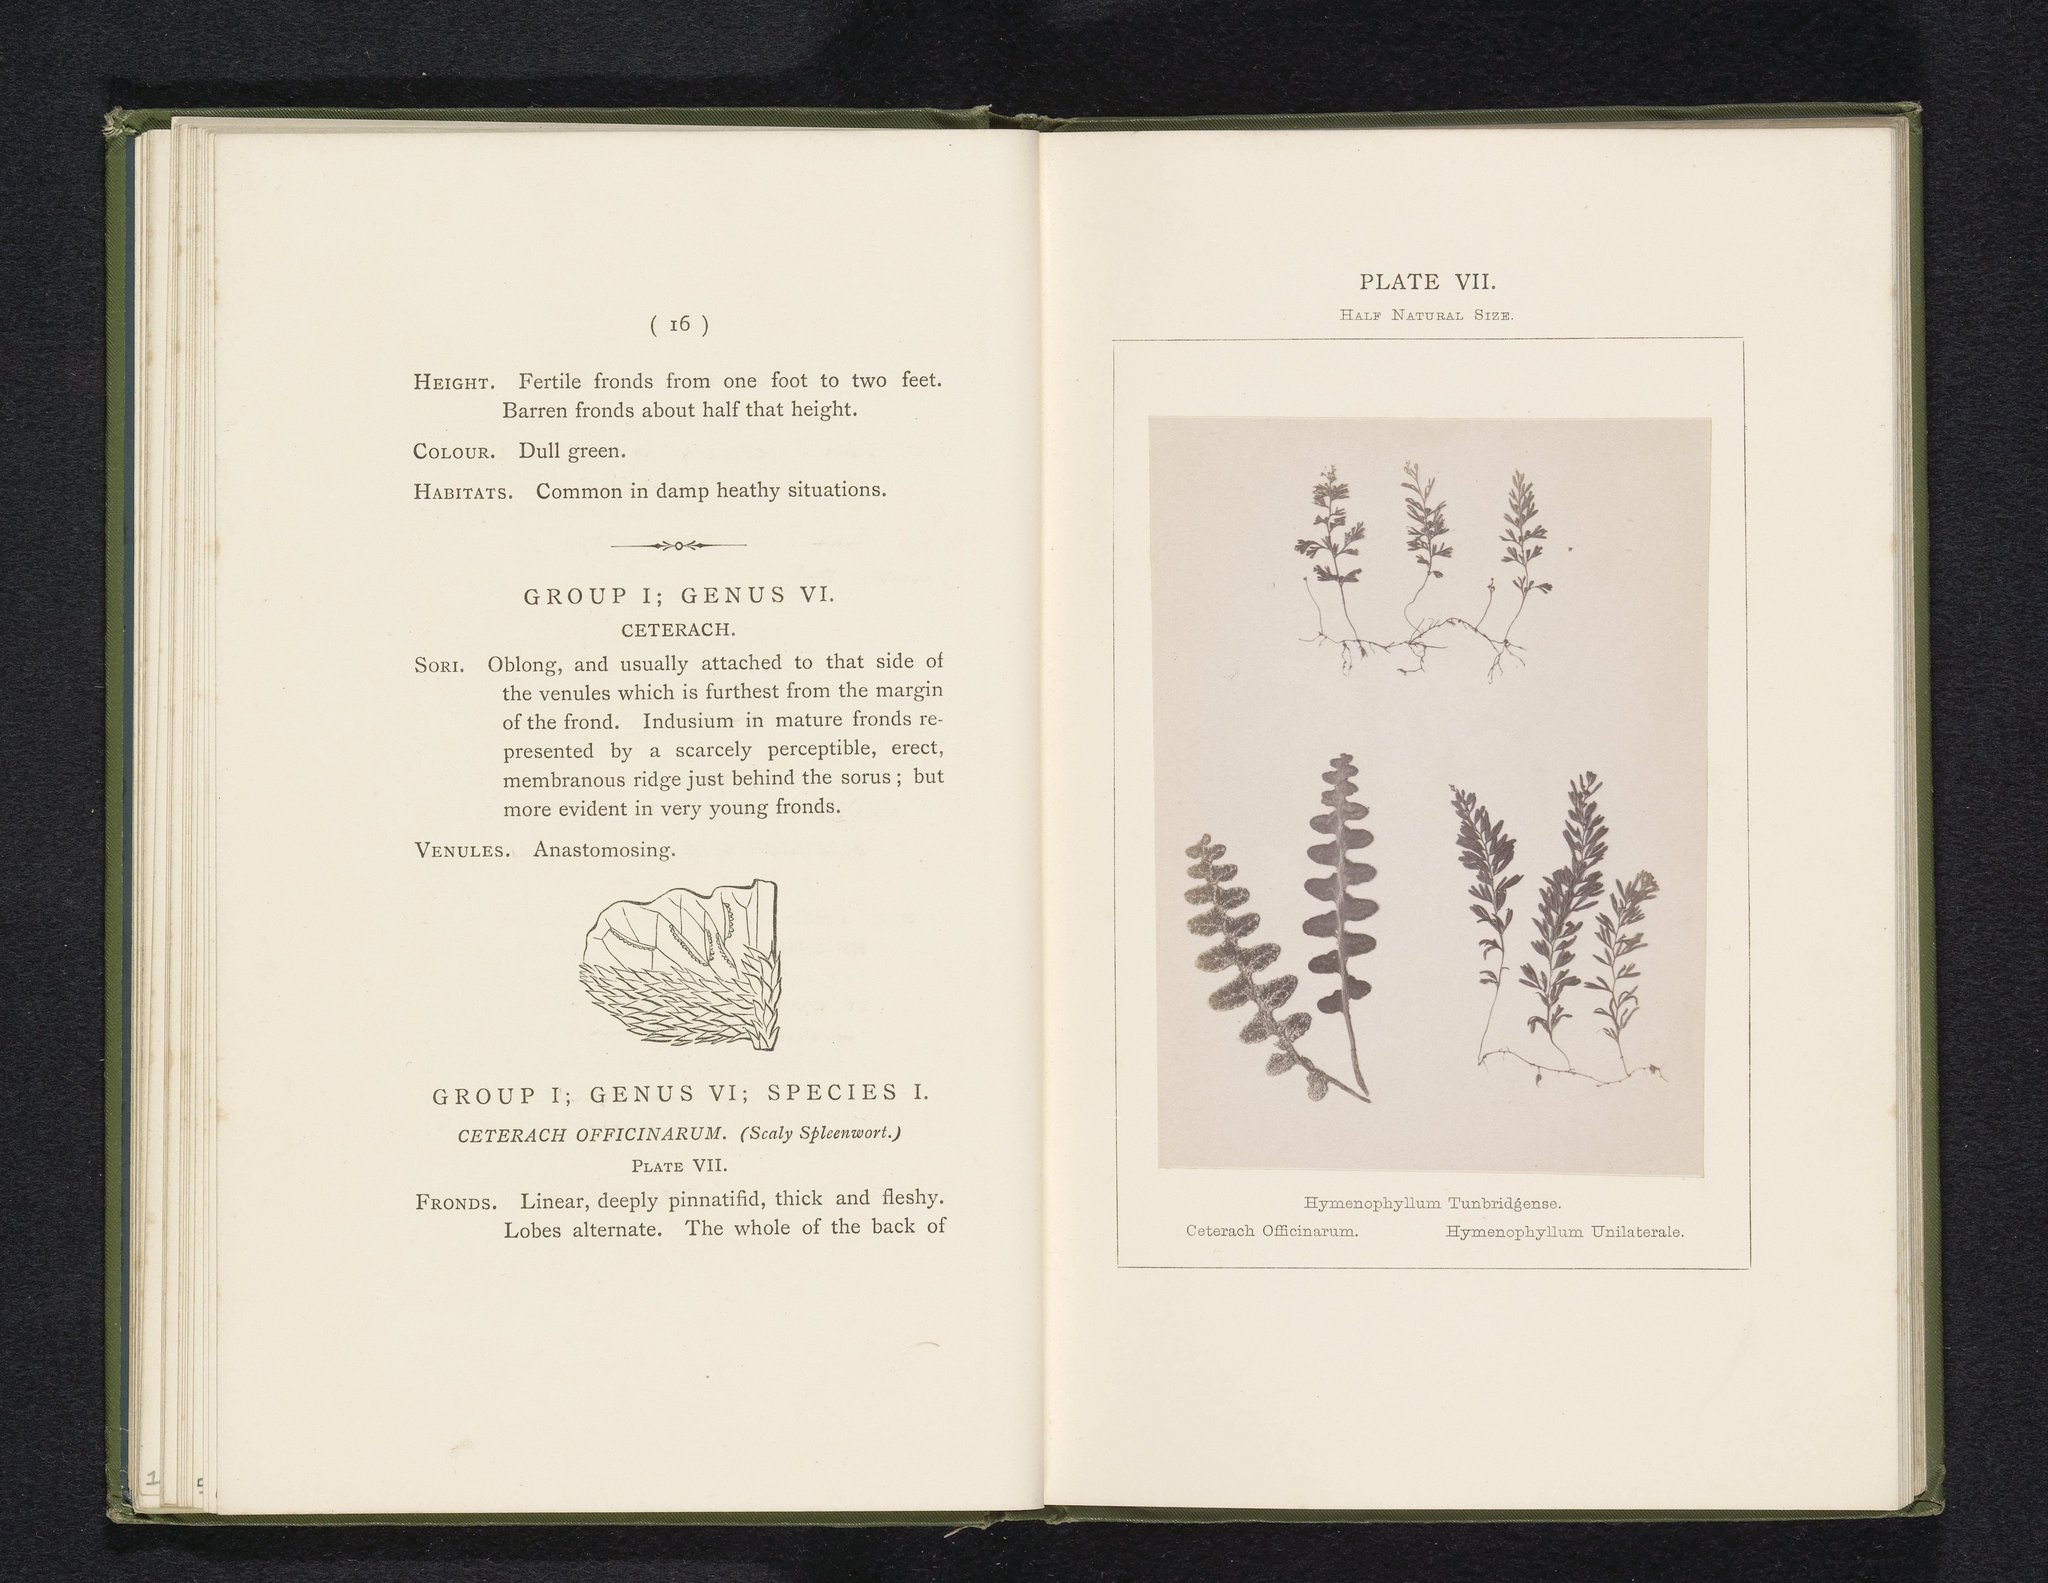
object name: photograph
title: Bladeren van de schubvaren en twee soorten Hymenophyllum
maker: sydney courtauld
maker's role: botanicus, fotograaf, schrijver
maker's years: 1840-1899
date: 1867-1877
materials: photographic support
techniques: albumen print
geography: england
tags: ferns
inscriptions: inscription: ‘Plate VII. Half natural size.’